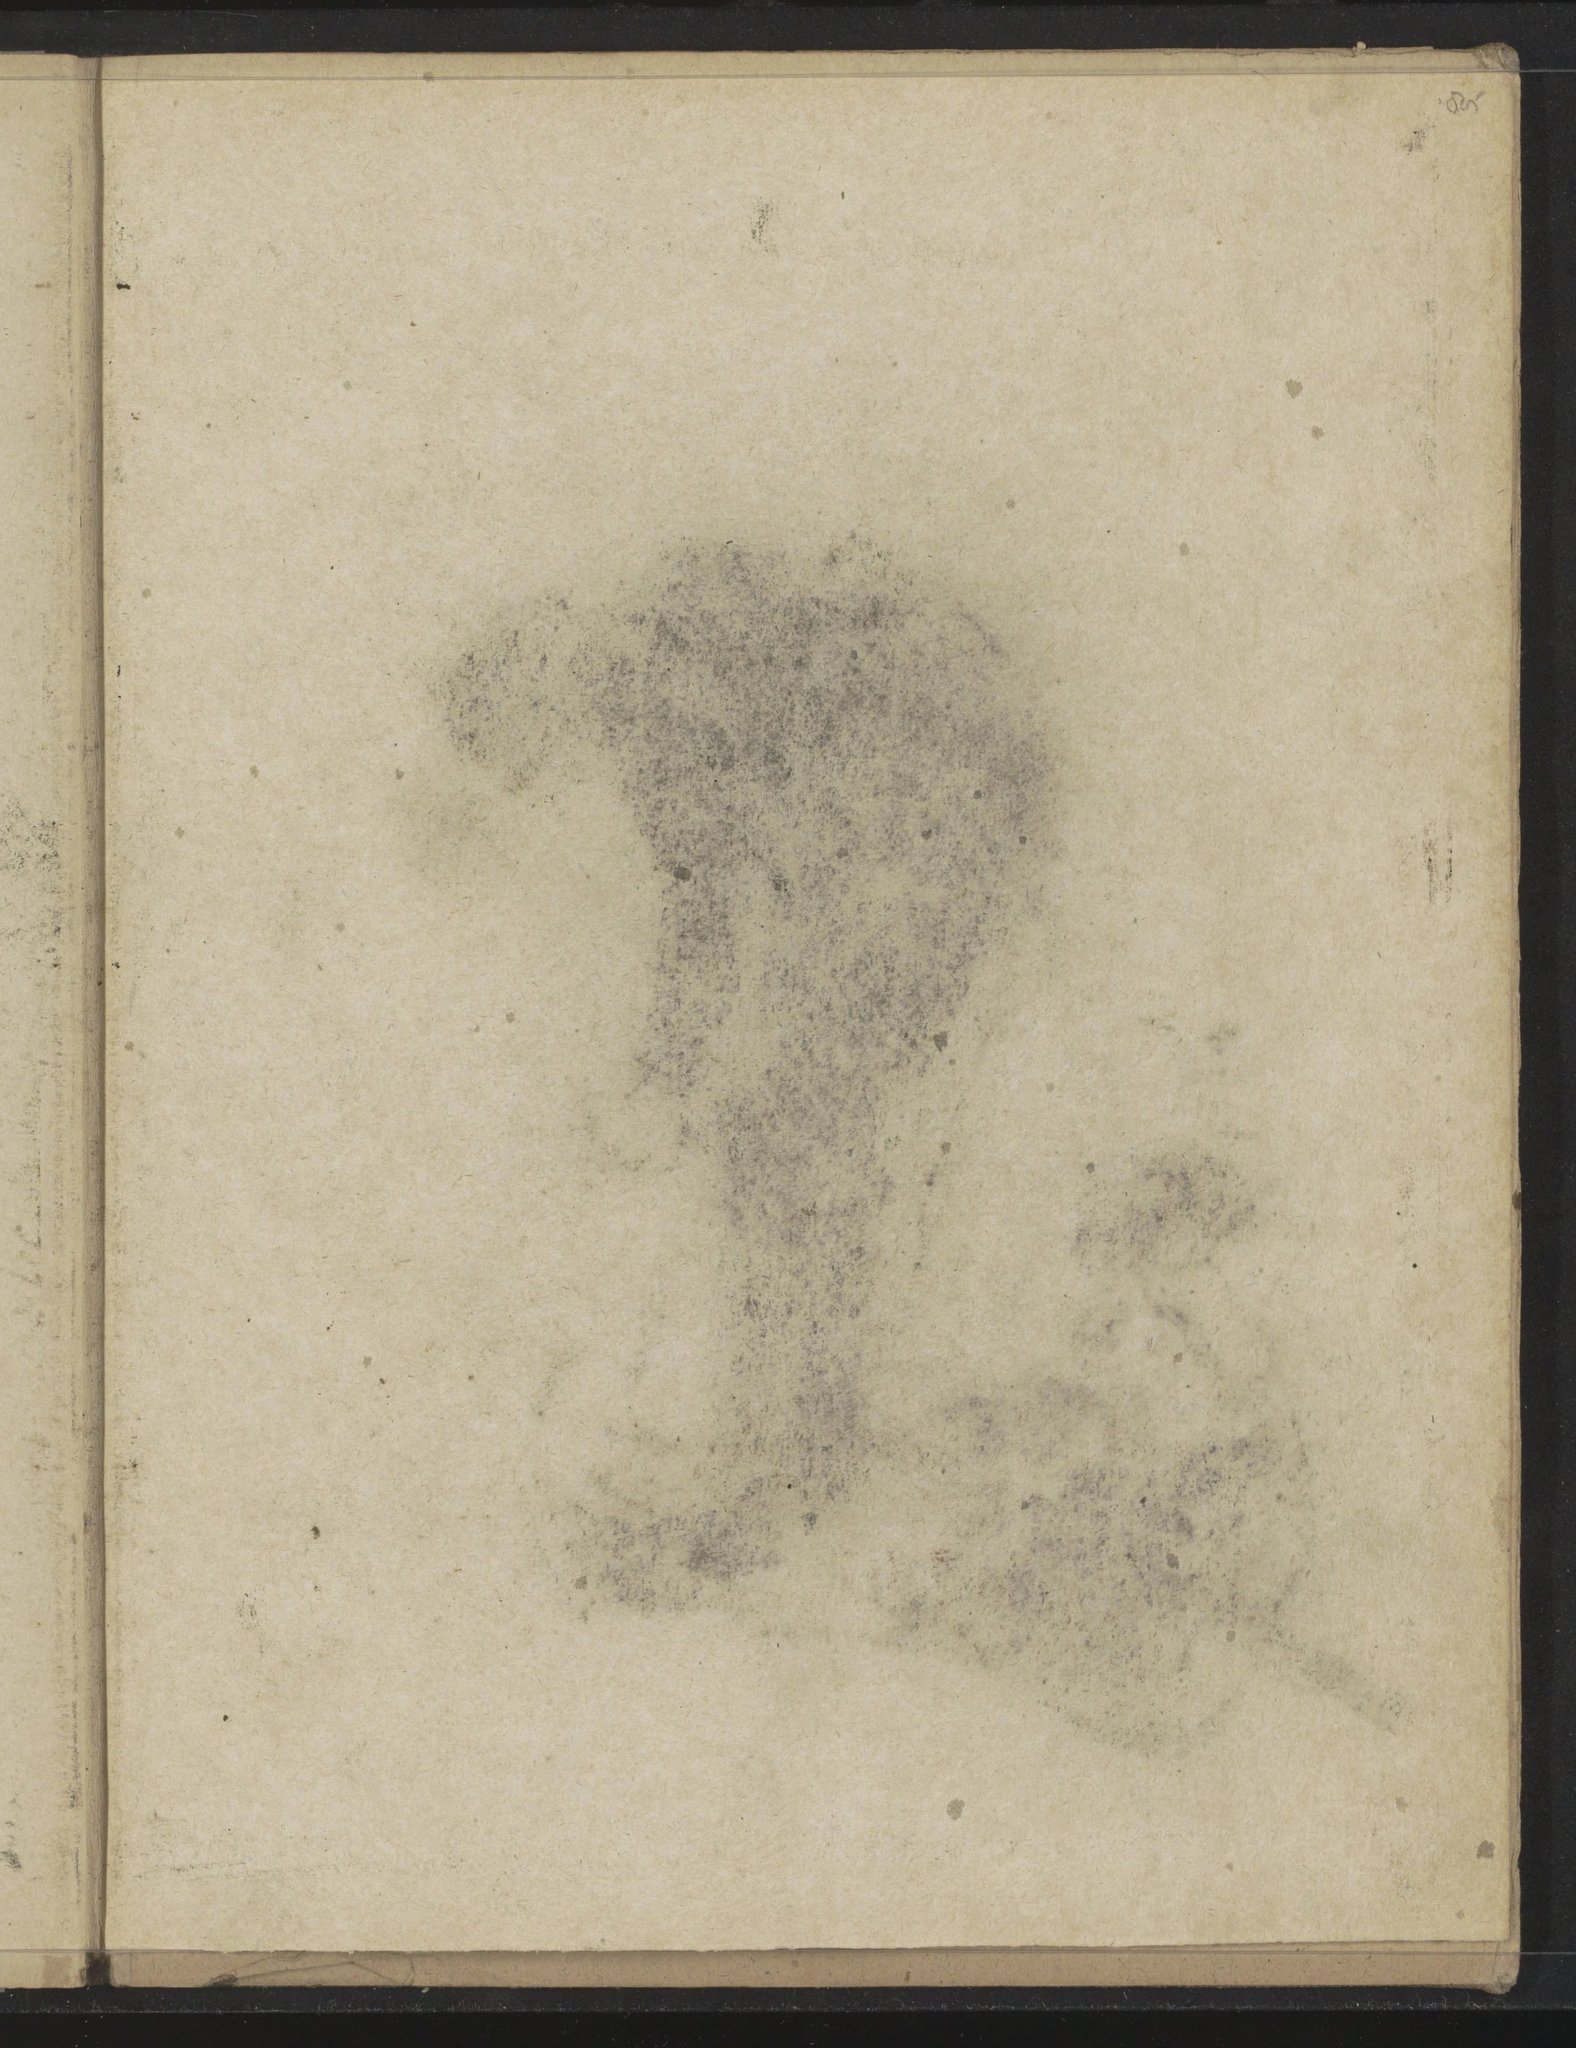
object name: sketchbook leaf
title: Abklatsch van de krijttekening op pagina 84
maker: willem witsen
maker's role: draughtsman, painter, print maker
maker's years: 1860-1923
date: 1887-1888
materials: paper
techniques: printmaking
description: Pagina 85 uit een schetsboek met 43 bladen.